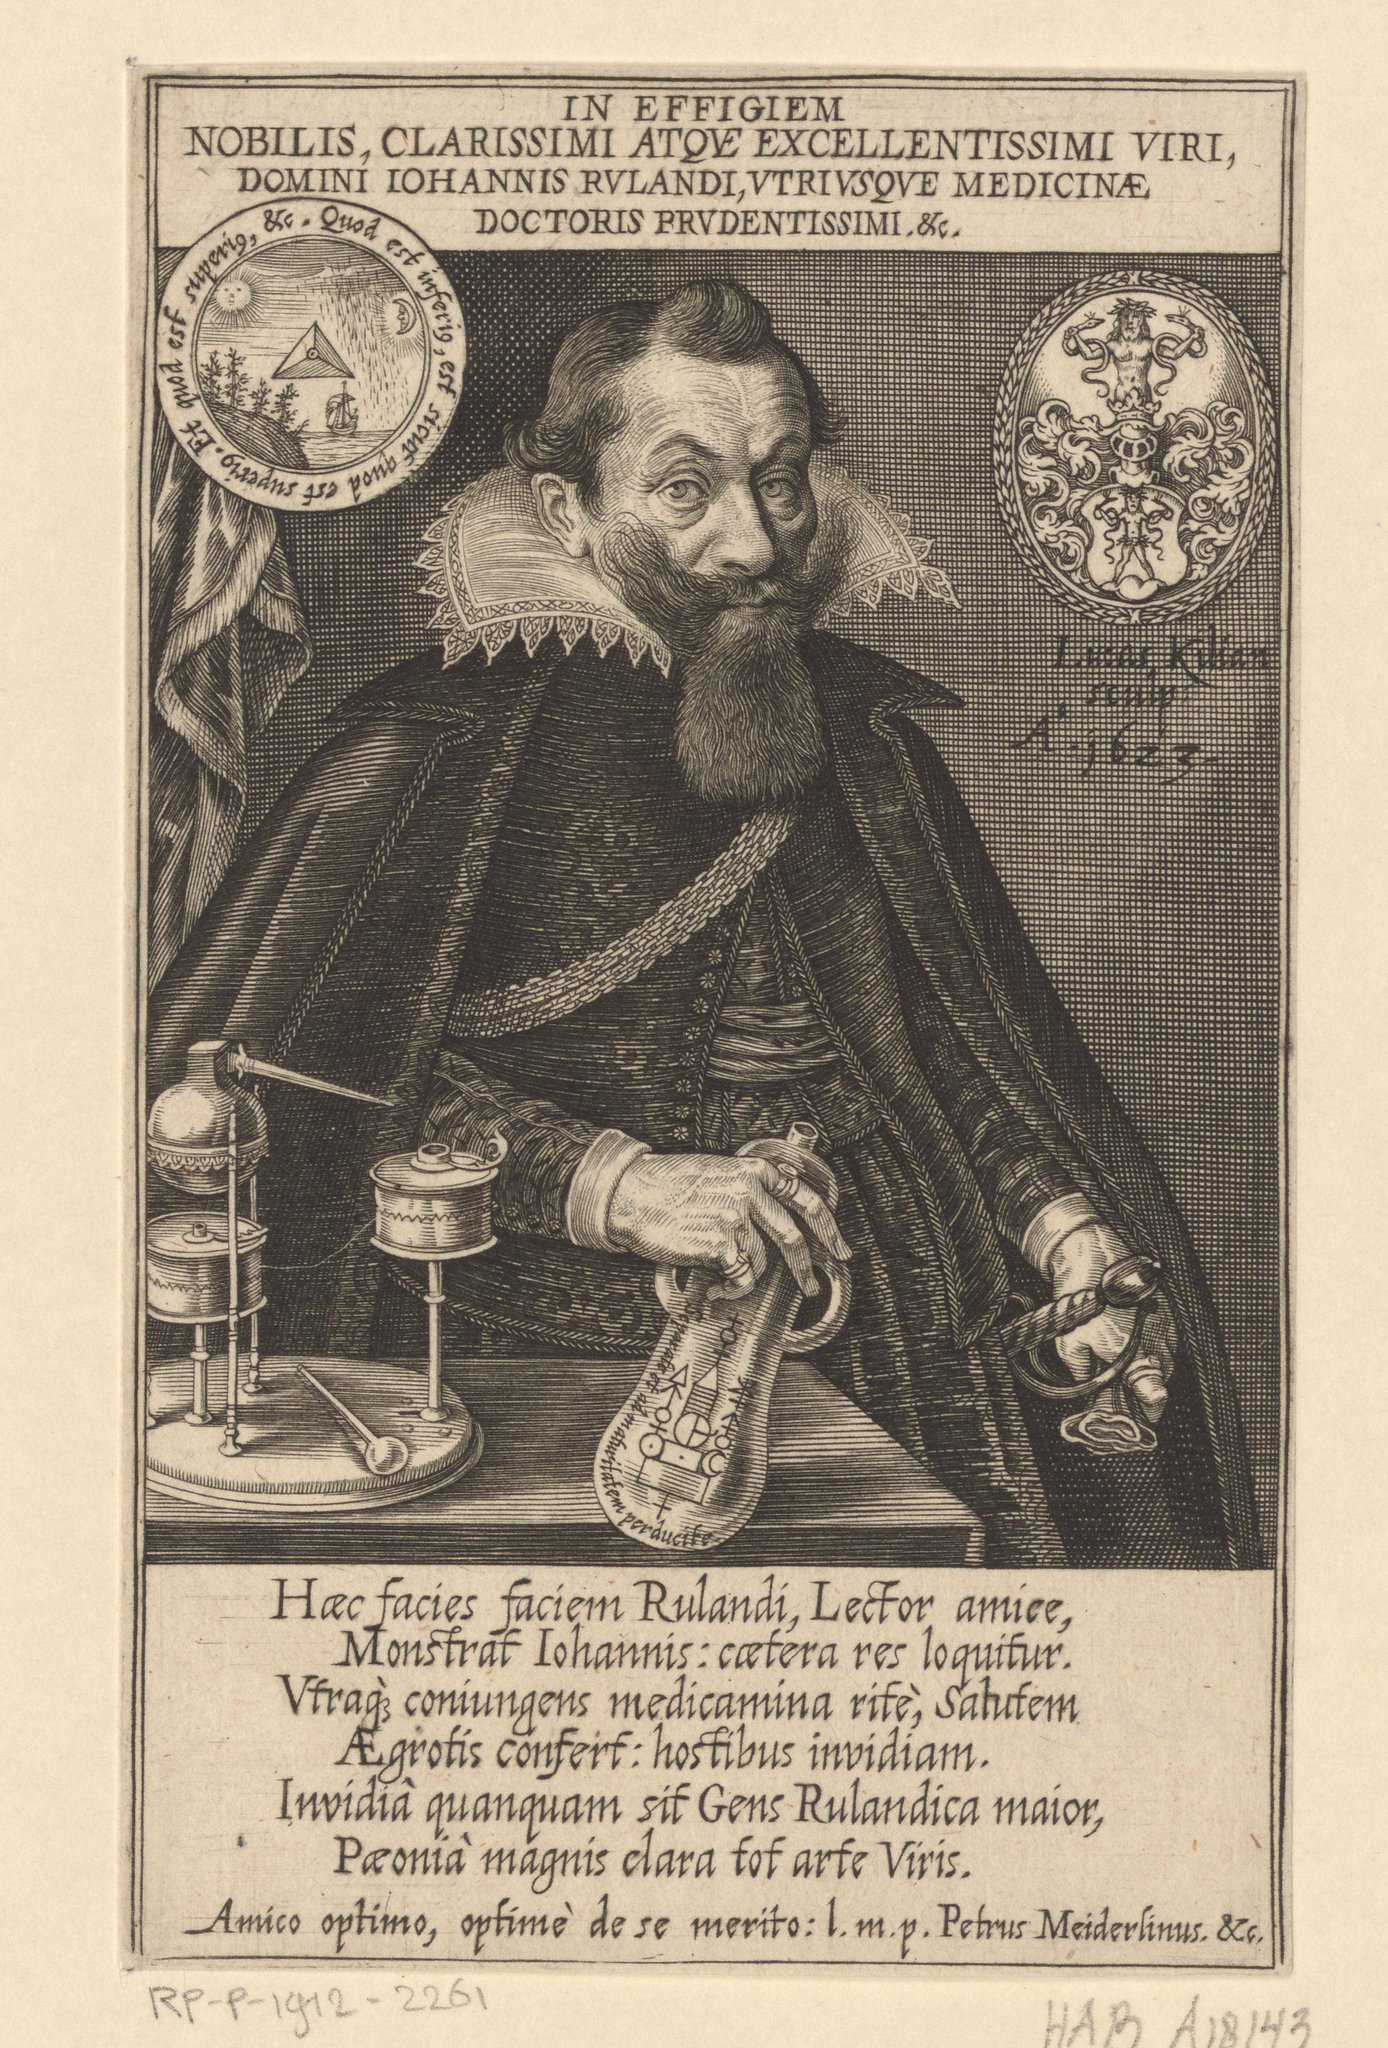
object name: print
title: Portret van Johann Ruland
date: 1623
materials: paper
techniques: engraving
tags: historical persons, armorial bearing, heraldry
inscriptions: collector's mark: Lugt 2228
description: Rechtsboven het portret zijn wapenschild, onder het portret een zesregelig vers.